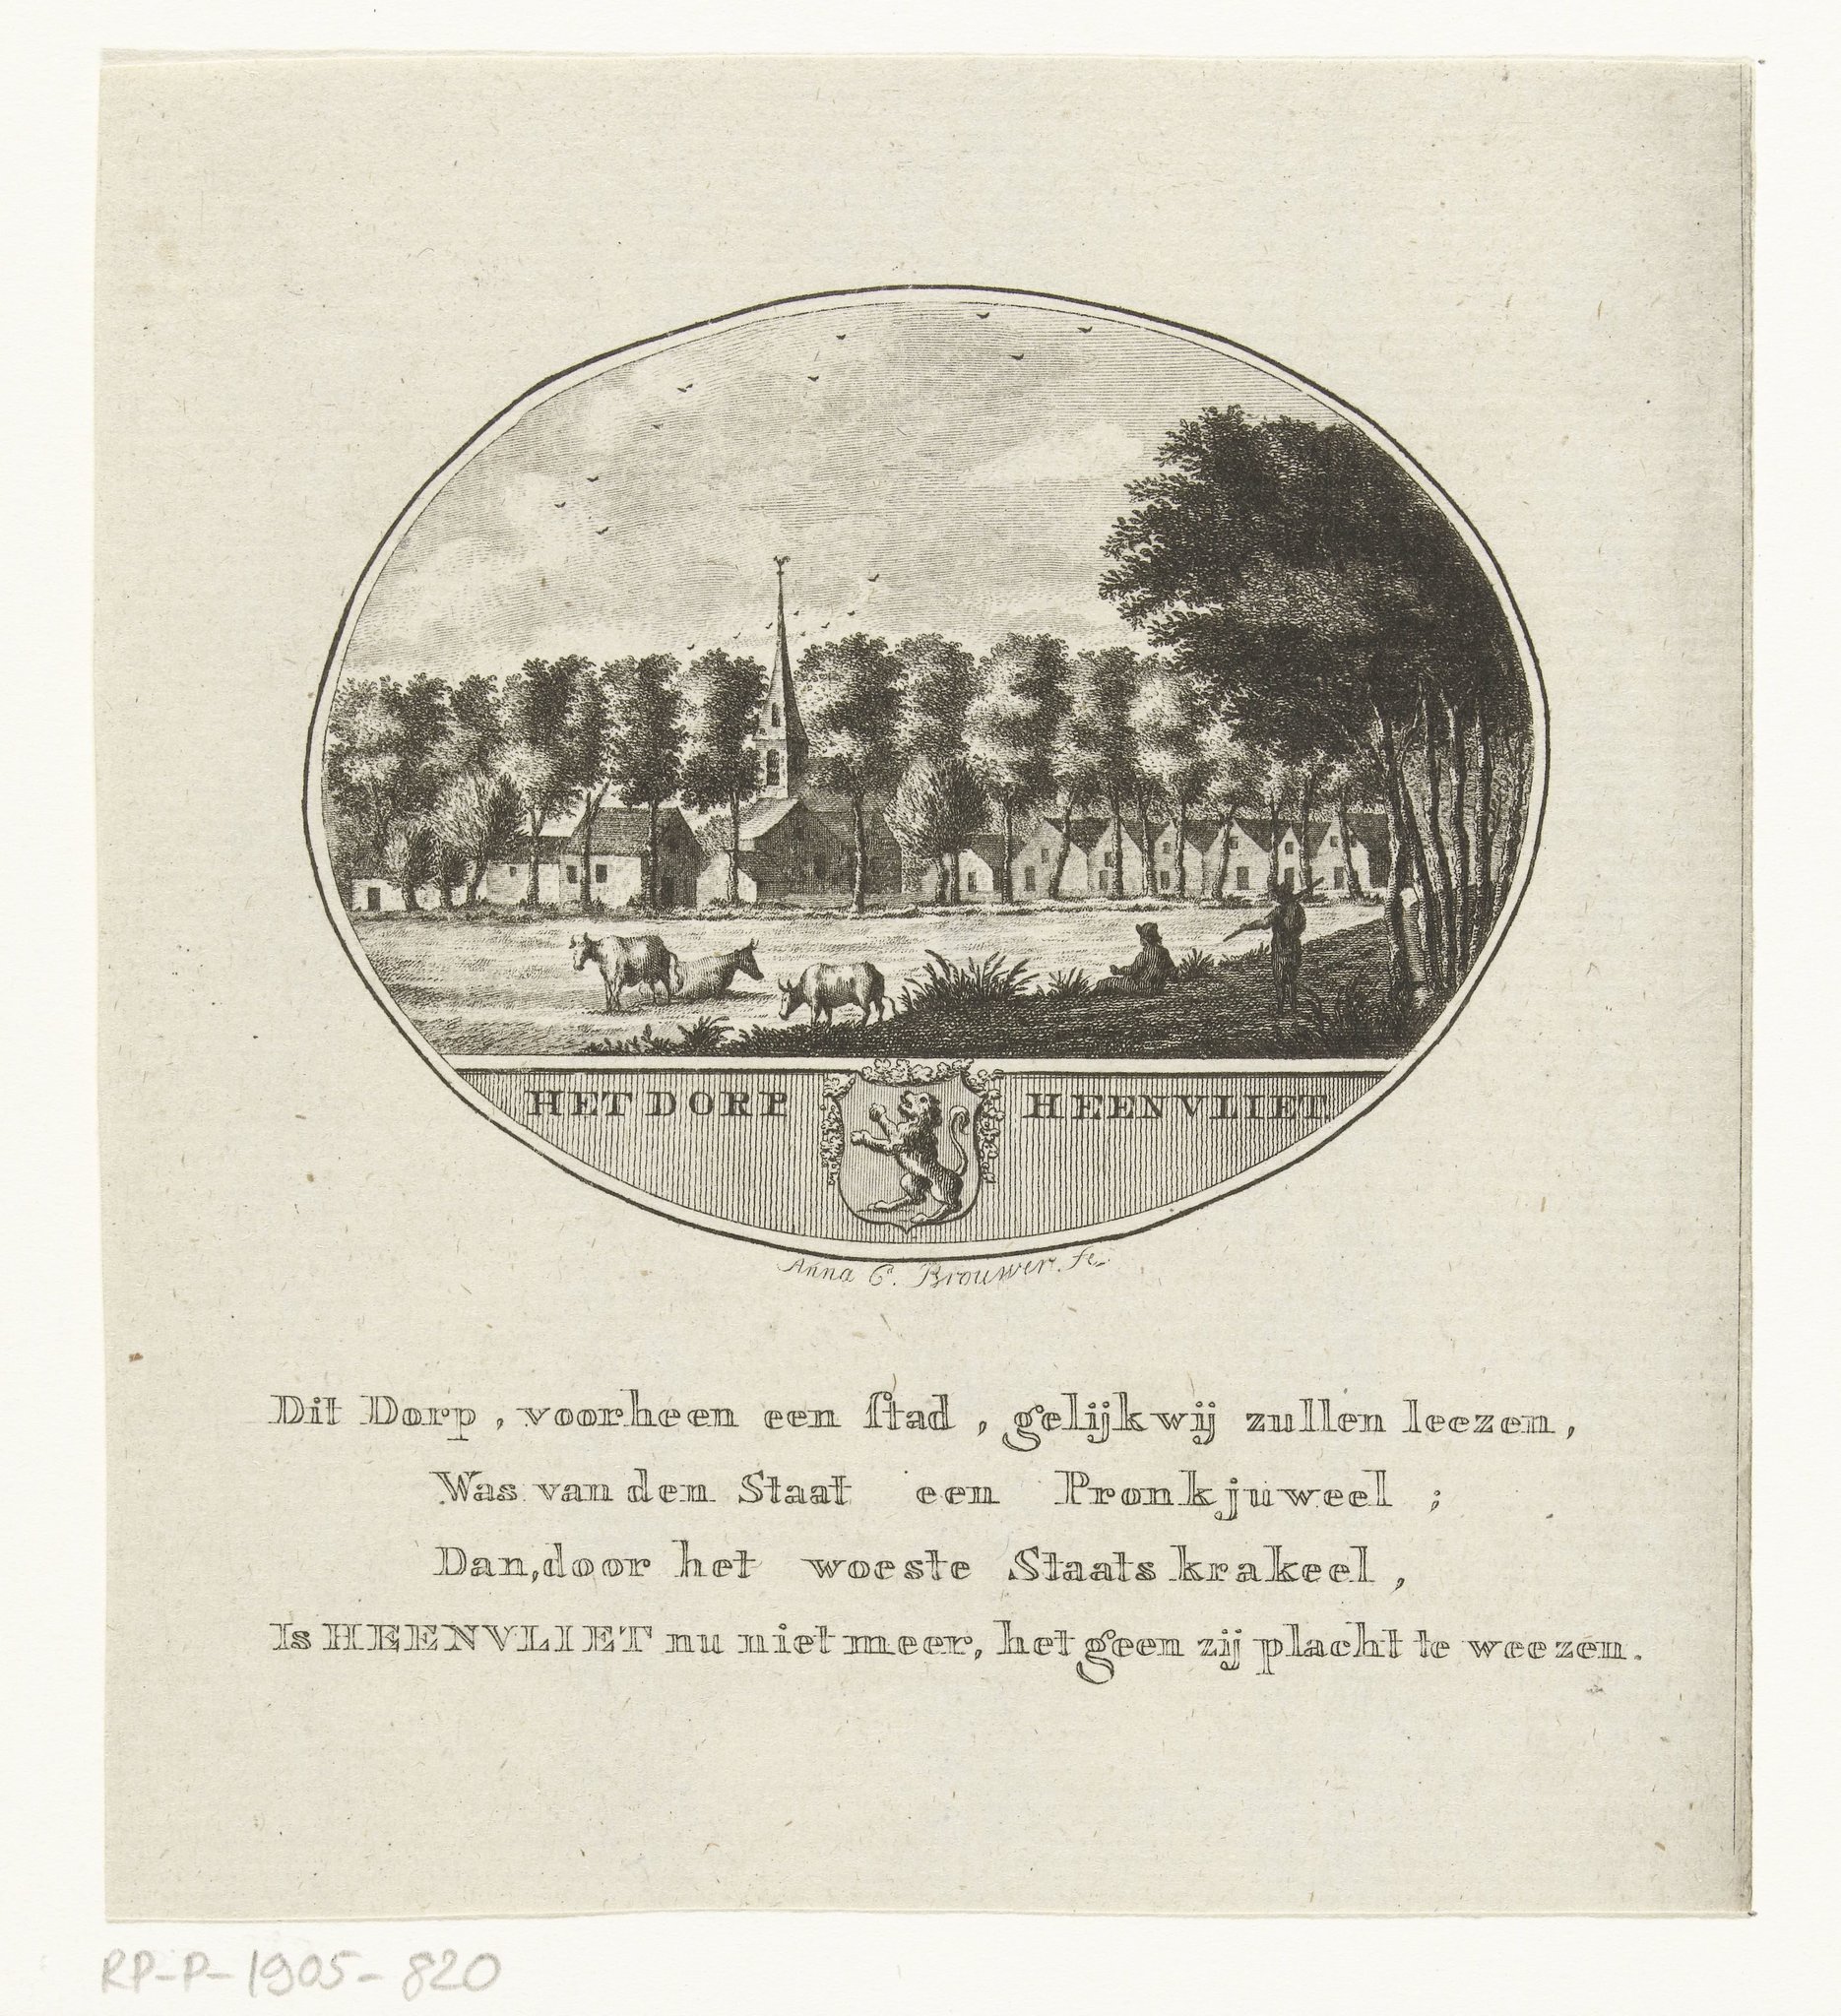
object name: print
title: Gezicht op het dorp Heenvliet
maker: anna catharina brouwer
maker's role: print maker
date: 1796-1798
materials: paper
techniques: etching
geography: amsterdam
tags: city-view in general; 'veduta'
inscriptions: collector's mark: Lugt 2228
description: afkomstig uit: L. van Ollefen, De Nederlandsche stad- en dorp-beschrijver. Deel 6, Amsterdam: Hendrik Arend Banse, 1798.